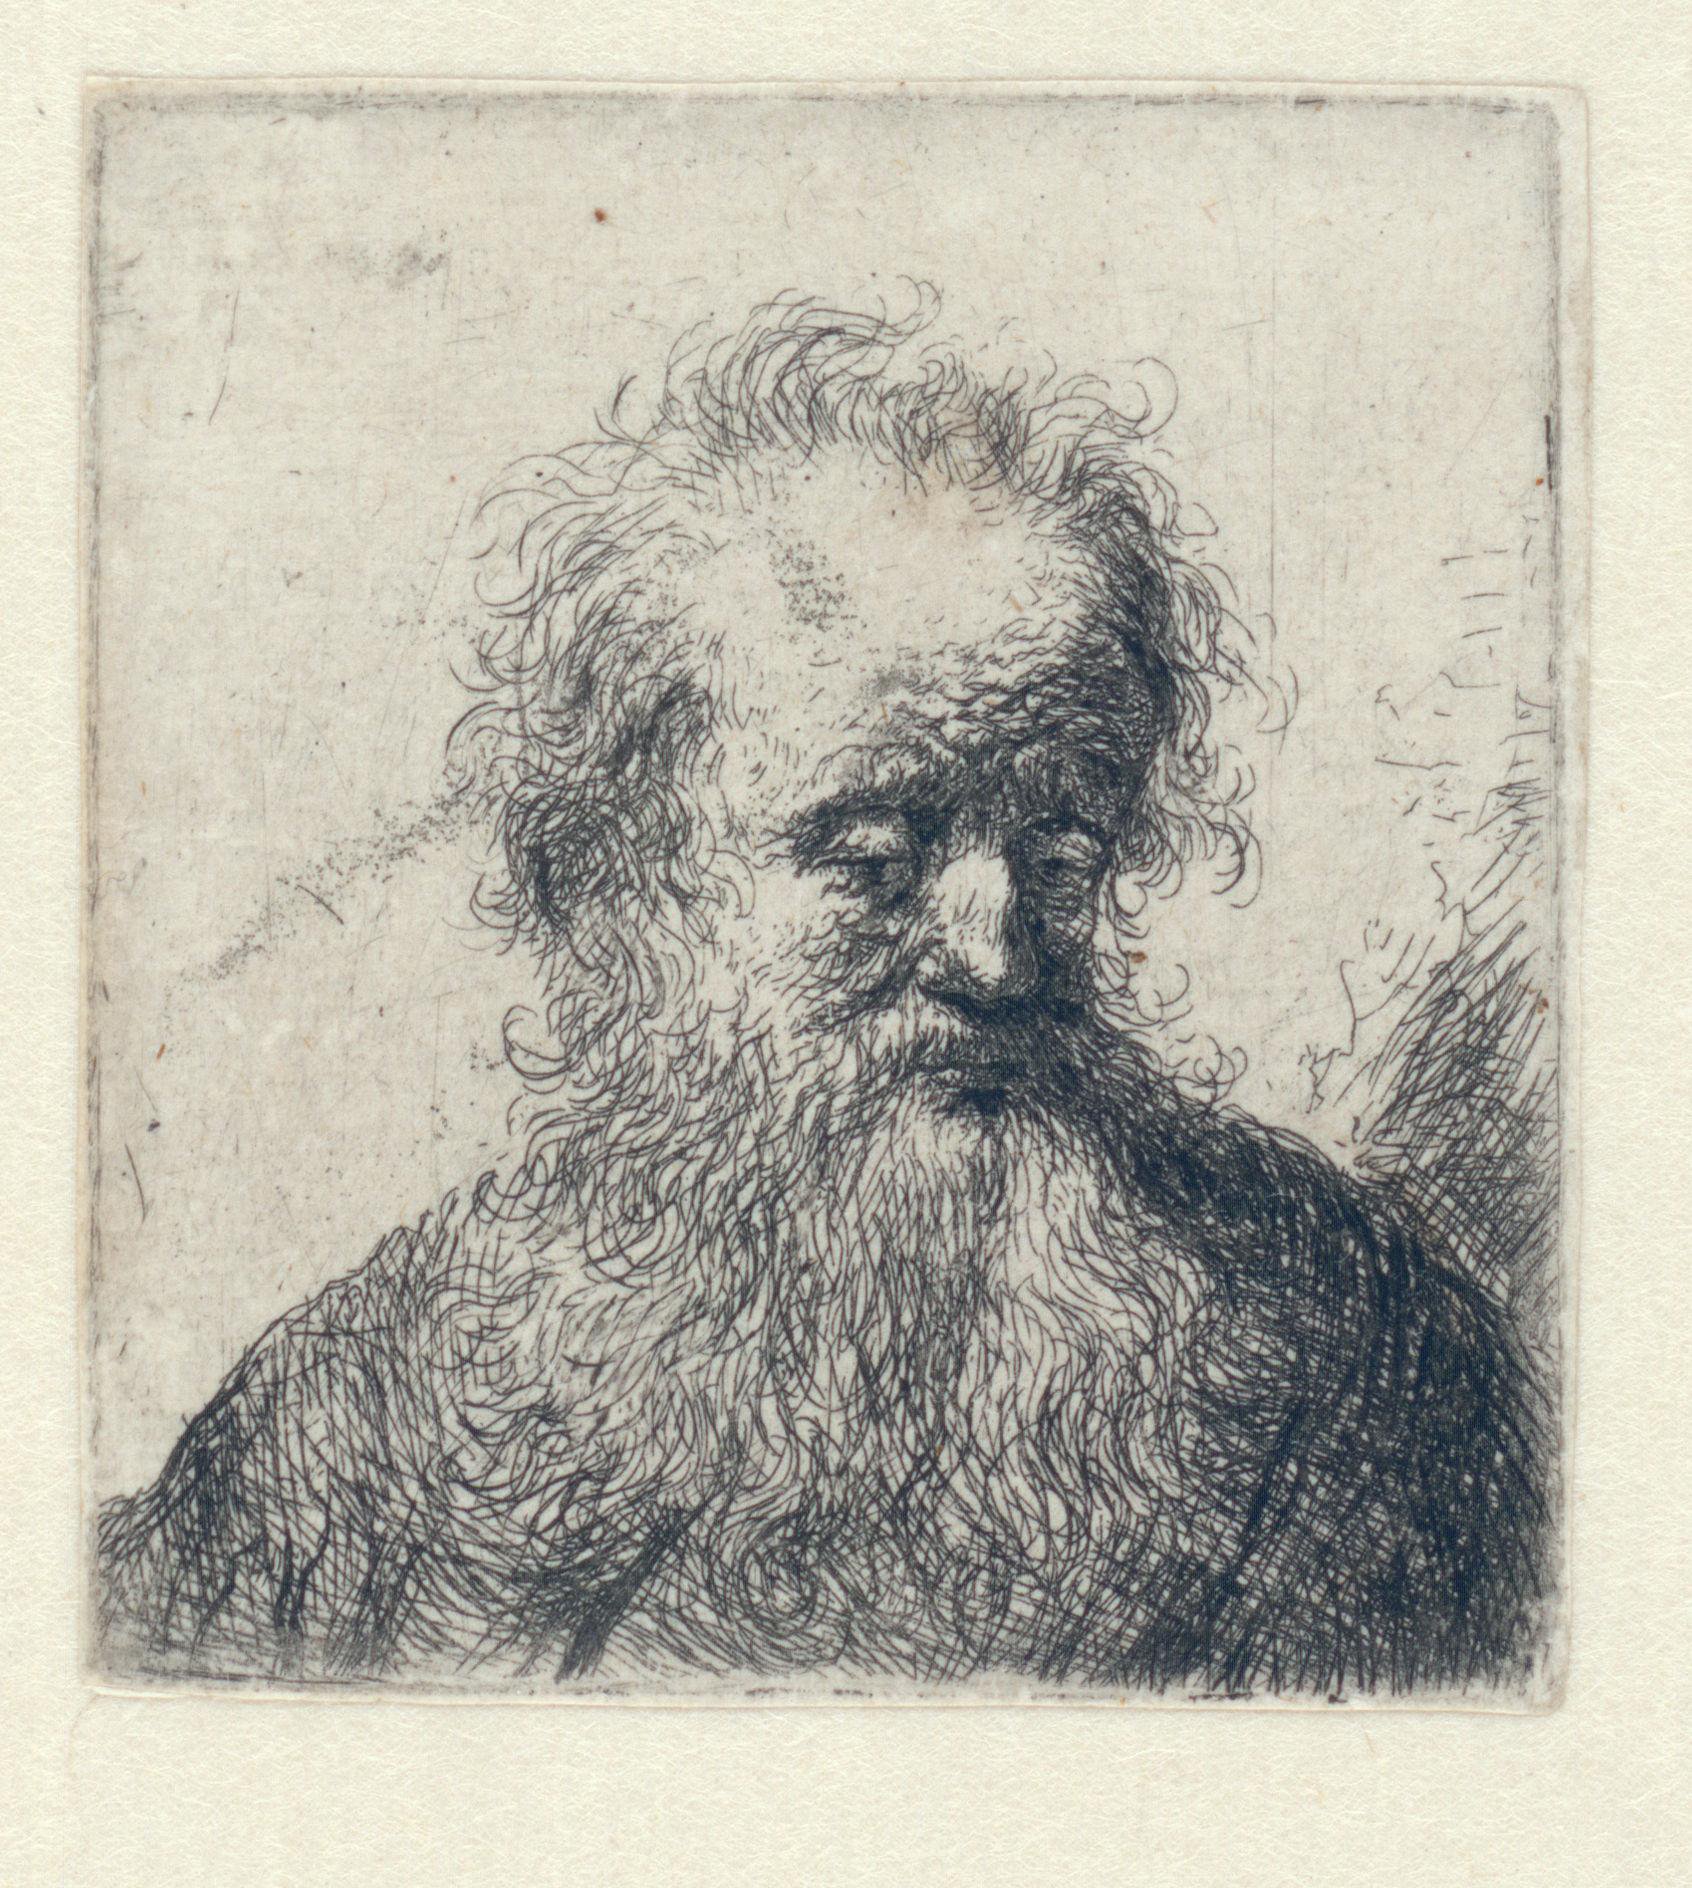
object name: print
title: Old man with a flowing beard: bust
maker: Anonymous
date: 1631-1700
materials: paper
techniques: etching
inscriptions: collector's mark: Lugt 240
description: Spiegelbeeldige kopie naar de gelijknamige prent van Rembrandt.